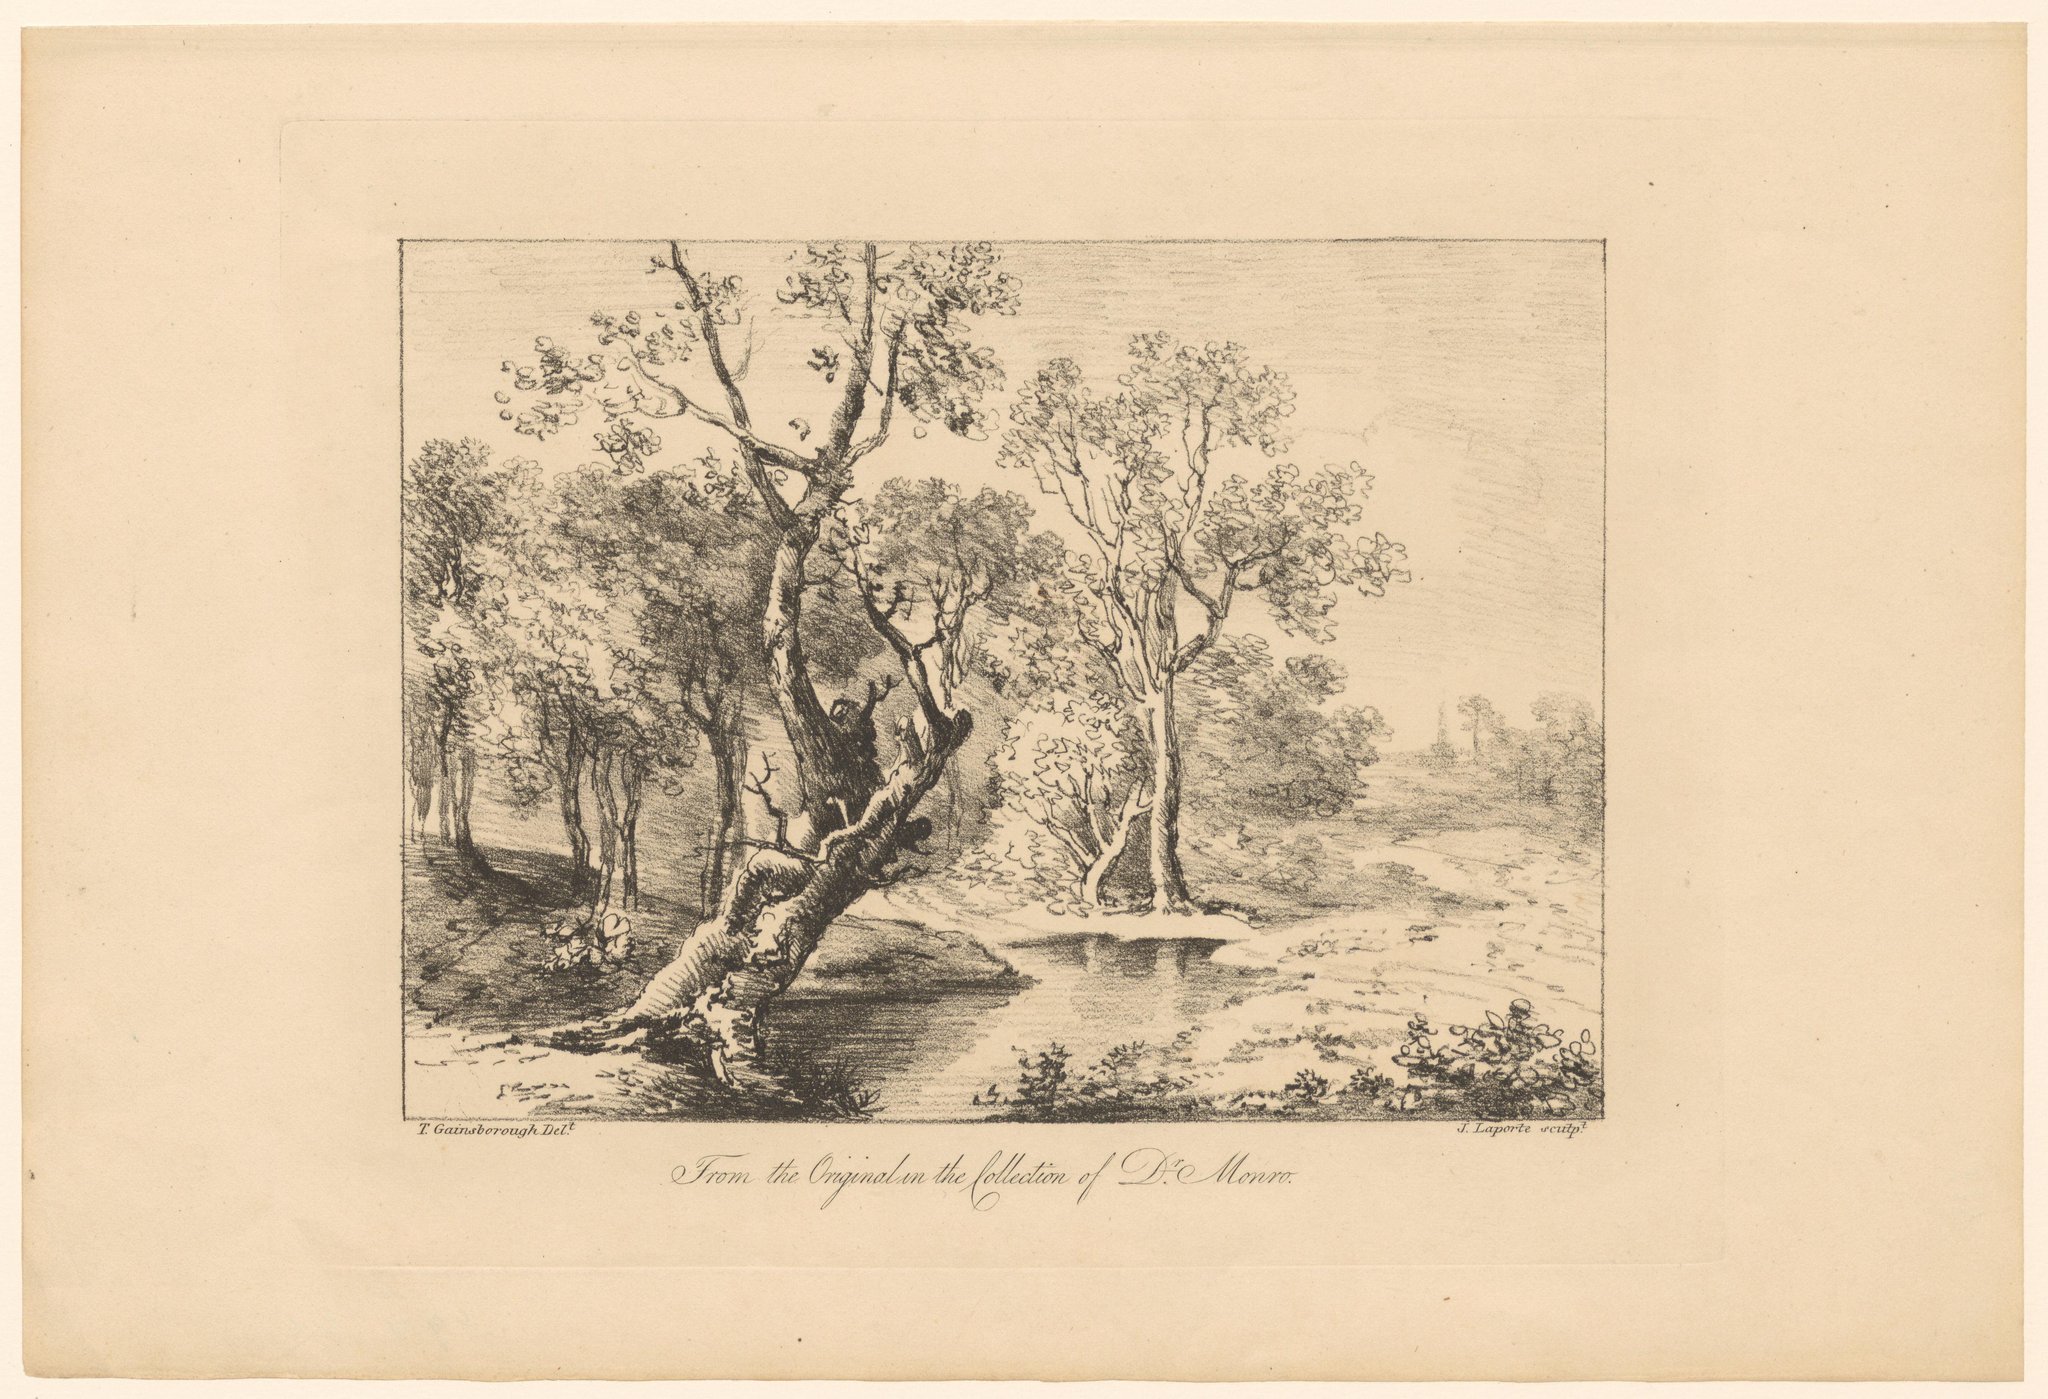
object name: print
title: Landschap met bomen aan het water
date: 1771-1839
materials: paper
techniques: soft ground etching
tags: swamps and polders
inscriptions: collector's mark: Lugt 2228